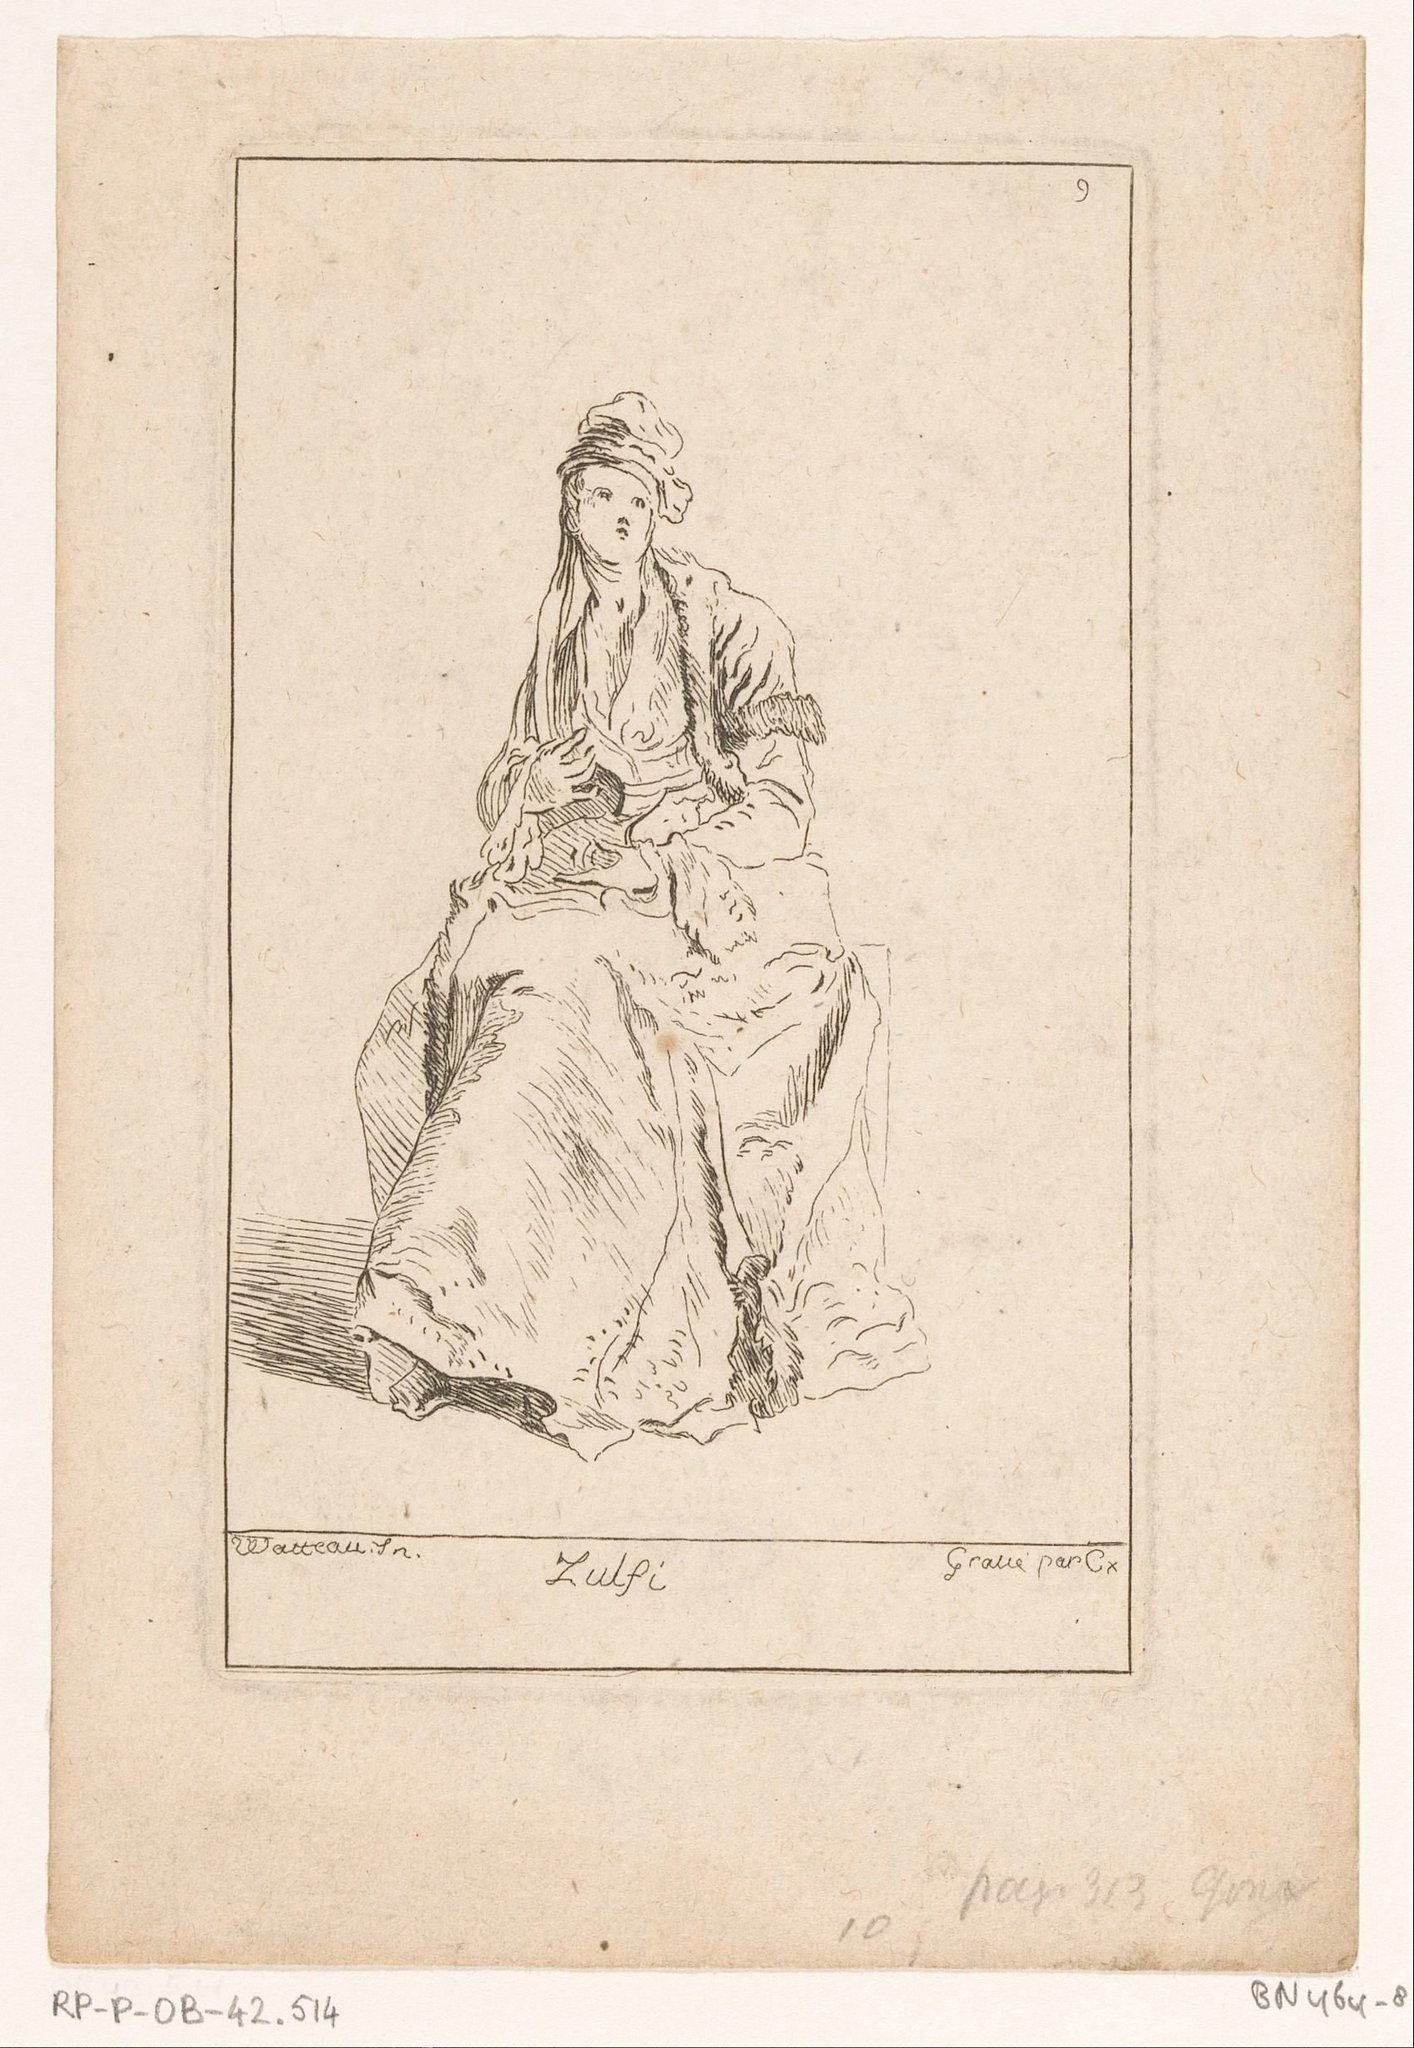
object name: print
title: Suite de Figures inventées par Watteau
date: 1702-1765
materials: paper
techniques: etching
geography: france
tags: sitting figure, adult woman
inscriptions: collector's mark: Lugt 2228, inscription: ‘Ju’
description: Maakt deel uit van een serie getiteld: "Suite de Figures inventées par Watteau" bestaande uit 24 platen plus titelprent naar figuren door Watteau. De platen zijn als volgt genummerd: 1-6, 8-17, 53, 63, 64 en 66-70.